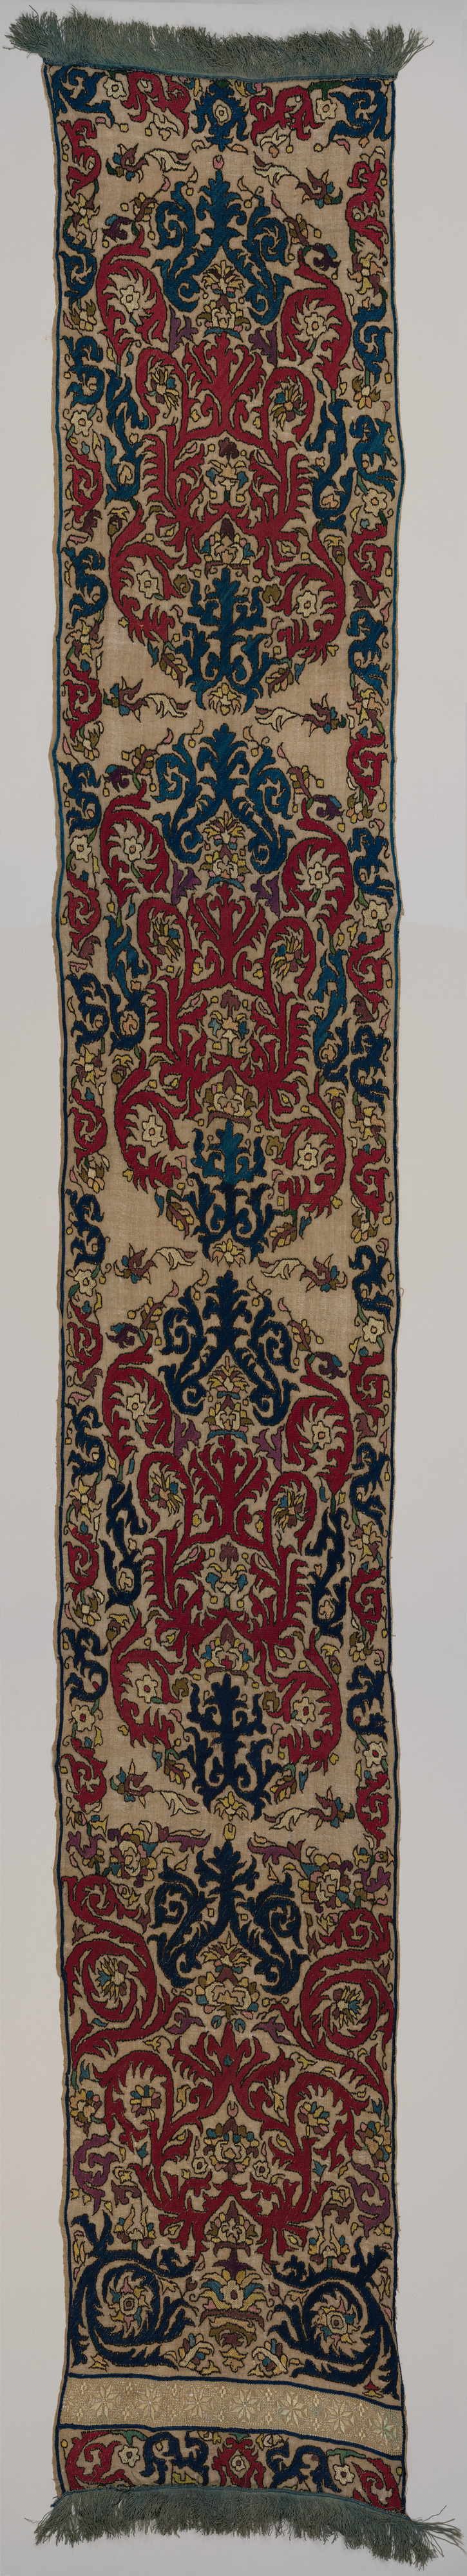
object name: fragment of a hanging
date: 1701-1800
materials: linen, silk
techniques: embroidery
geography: algeria